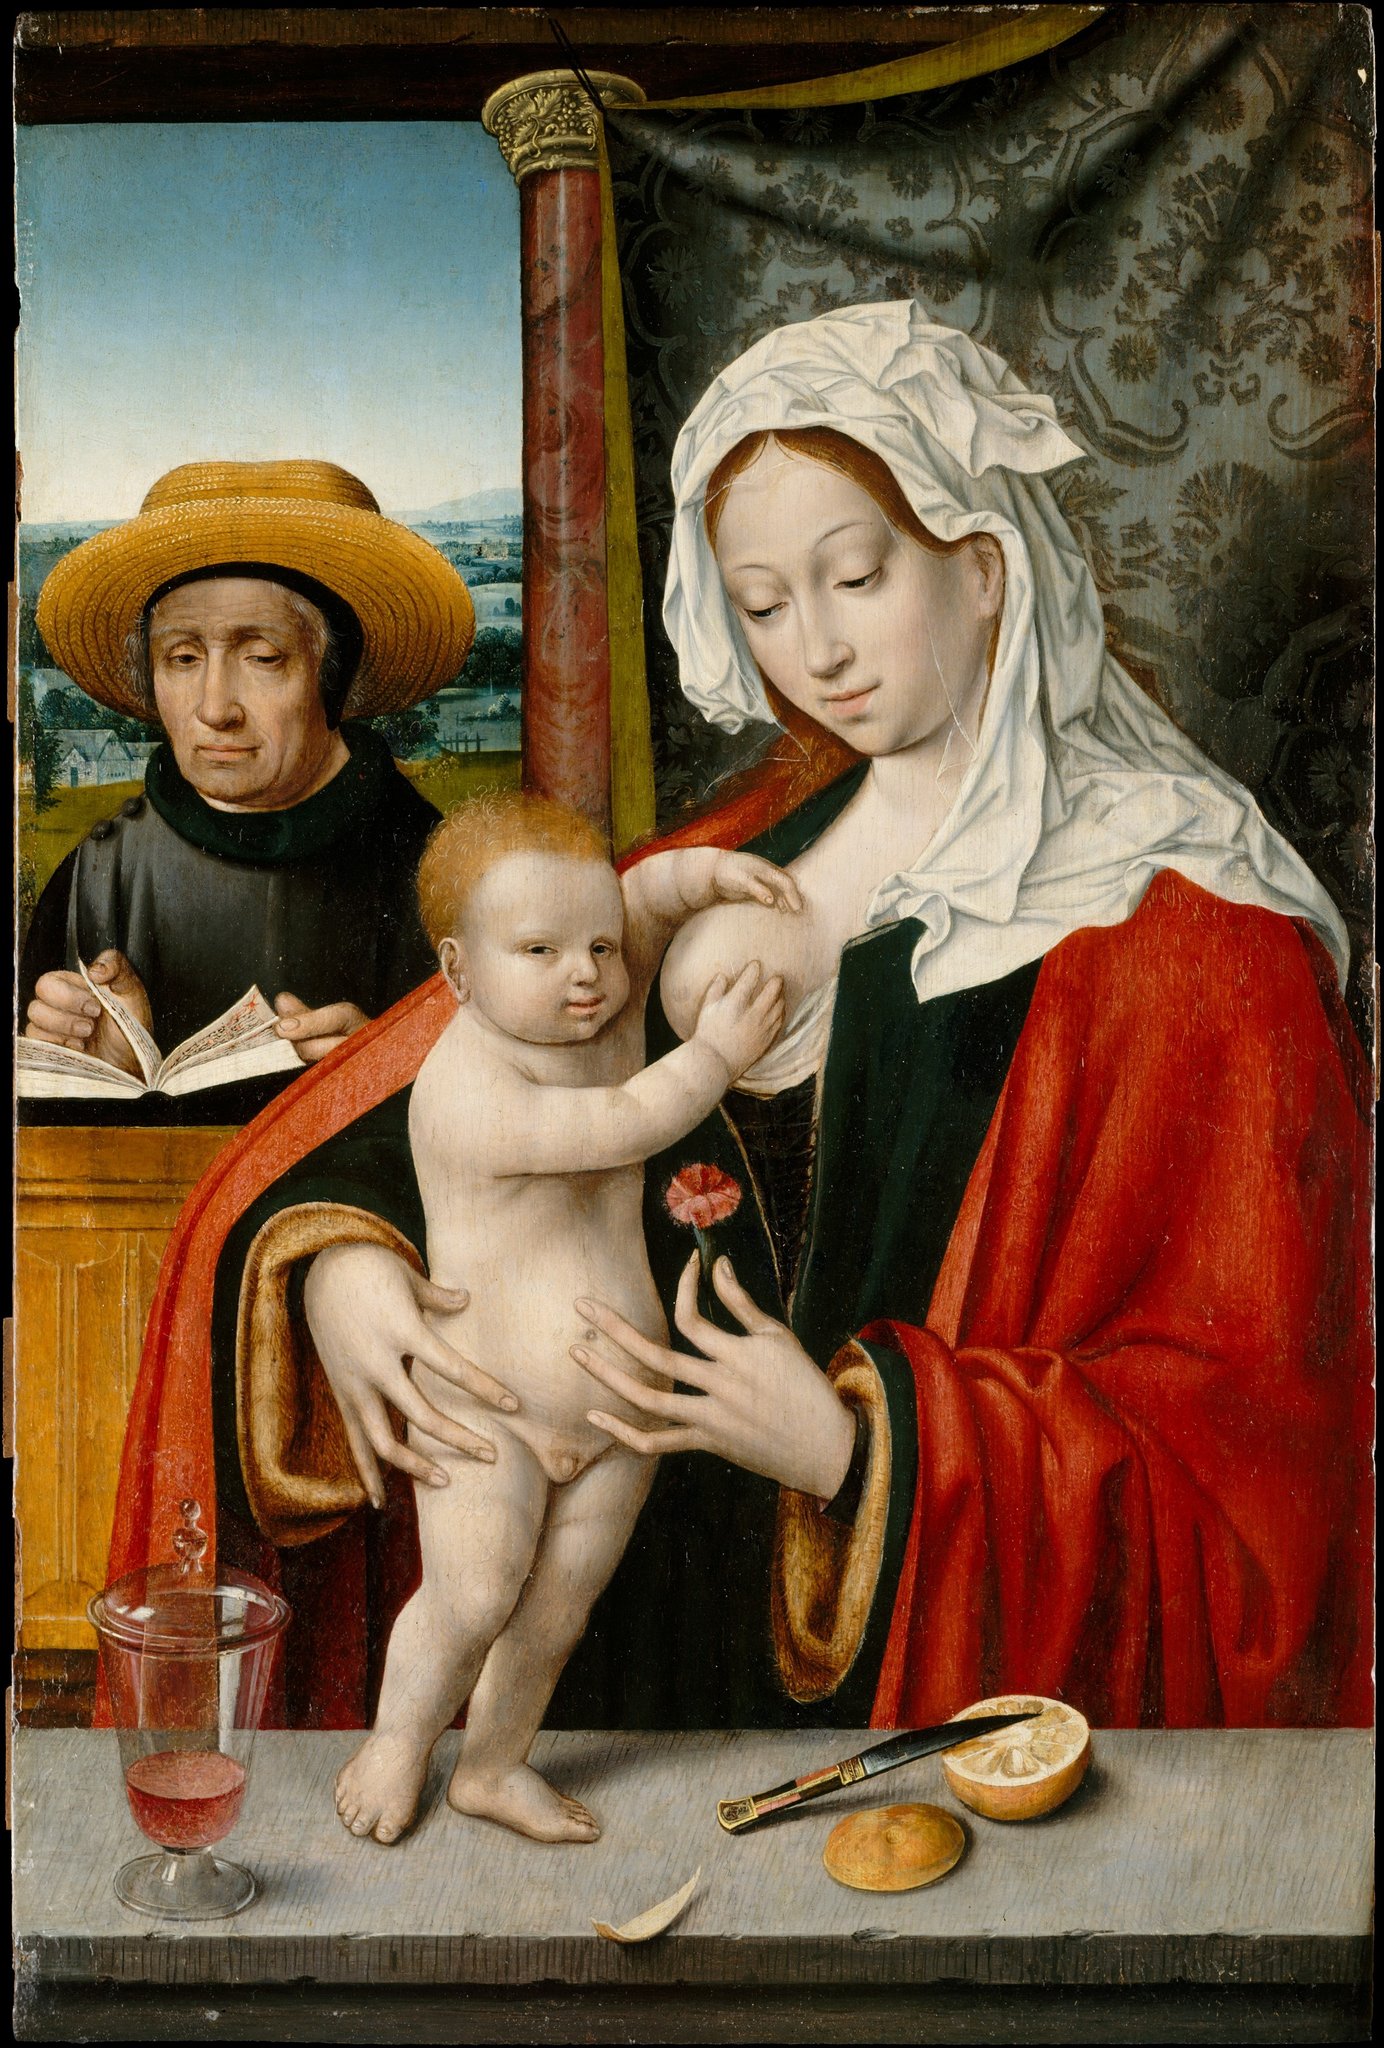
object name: painting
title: The Holy Family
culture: dutch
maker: joos van cleve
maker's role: artist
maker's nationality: netherlandish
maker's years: 1485-1541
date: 1527-1533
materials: wood, oil, panel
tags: christ,holy family,virgin mary